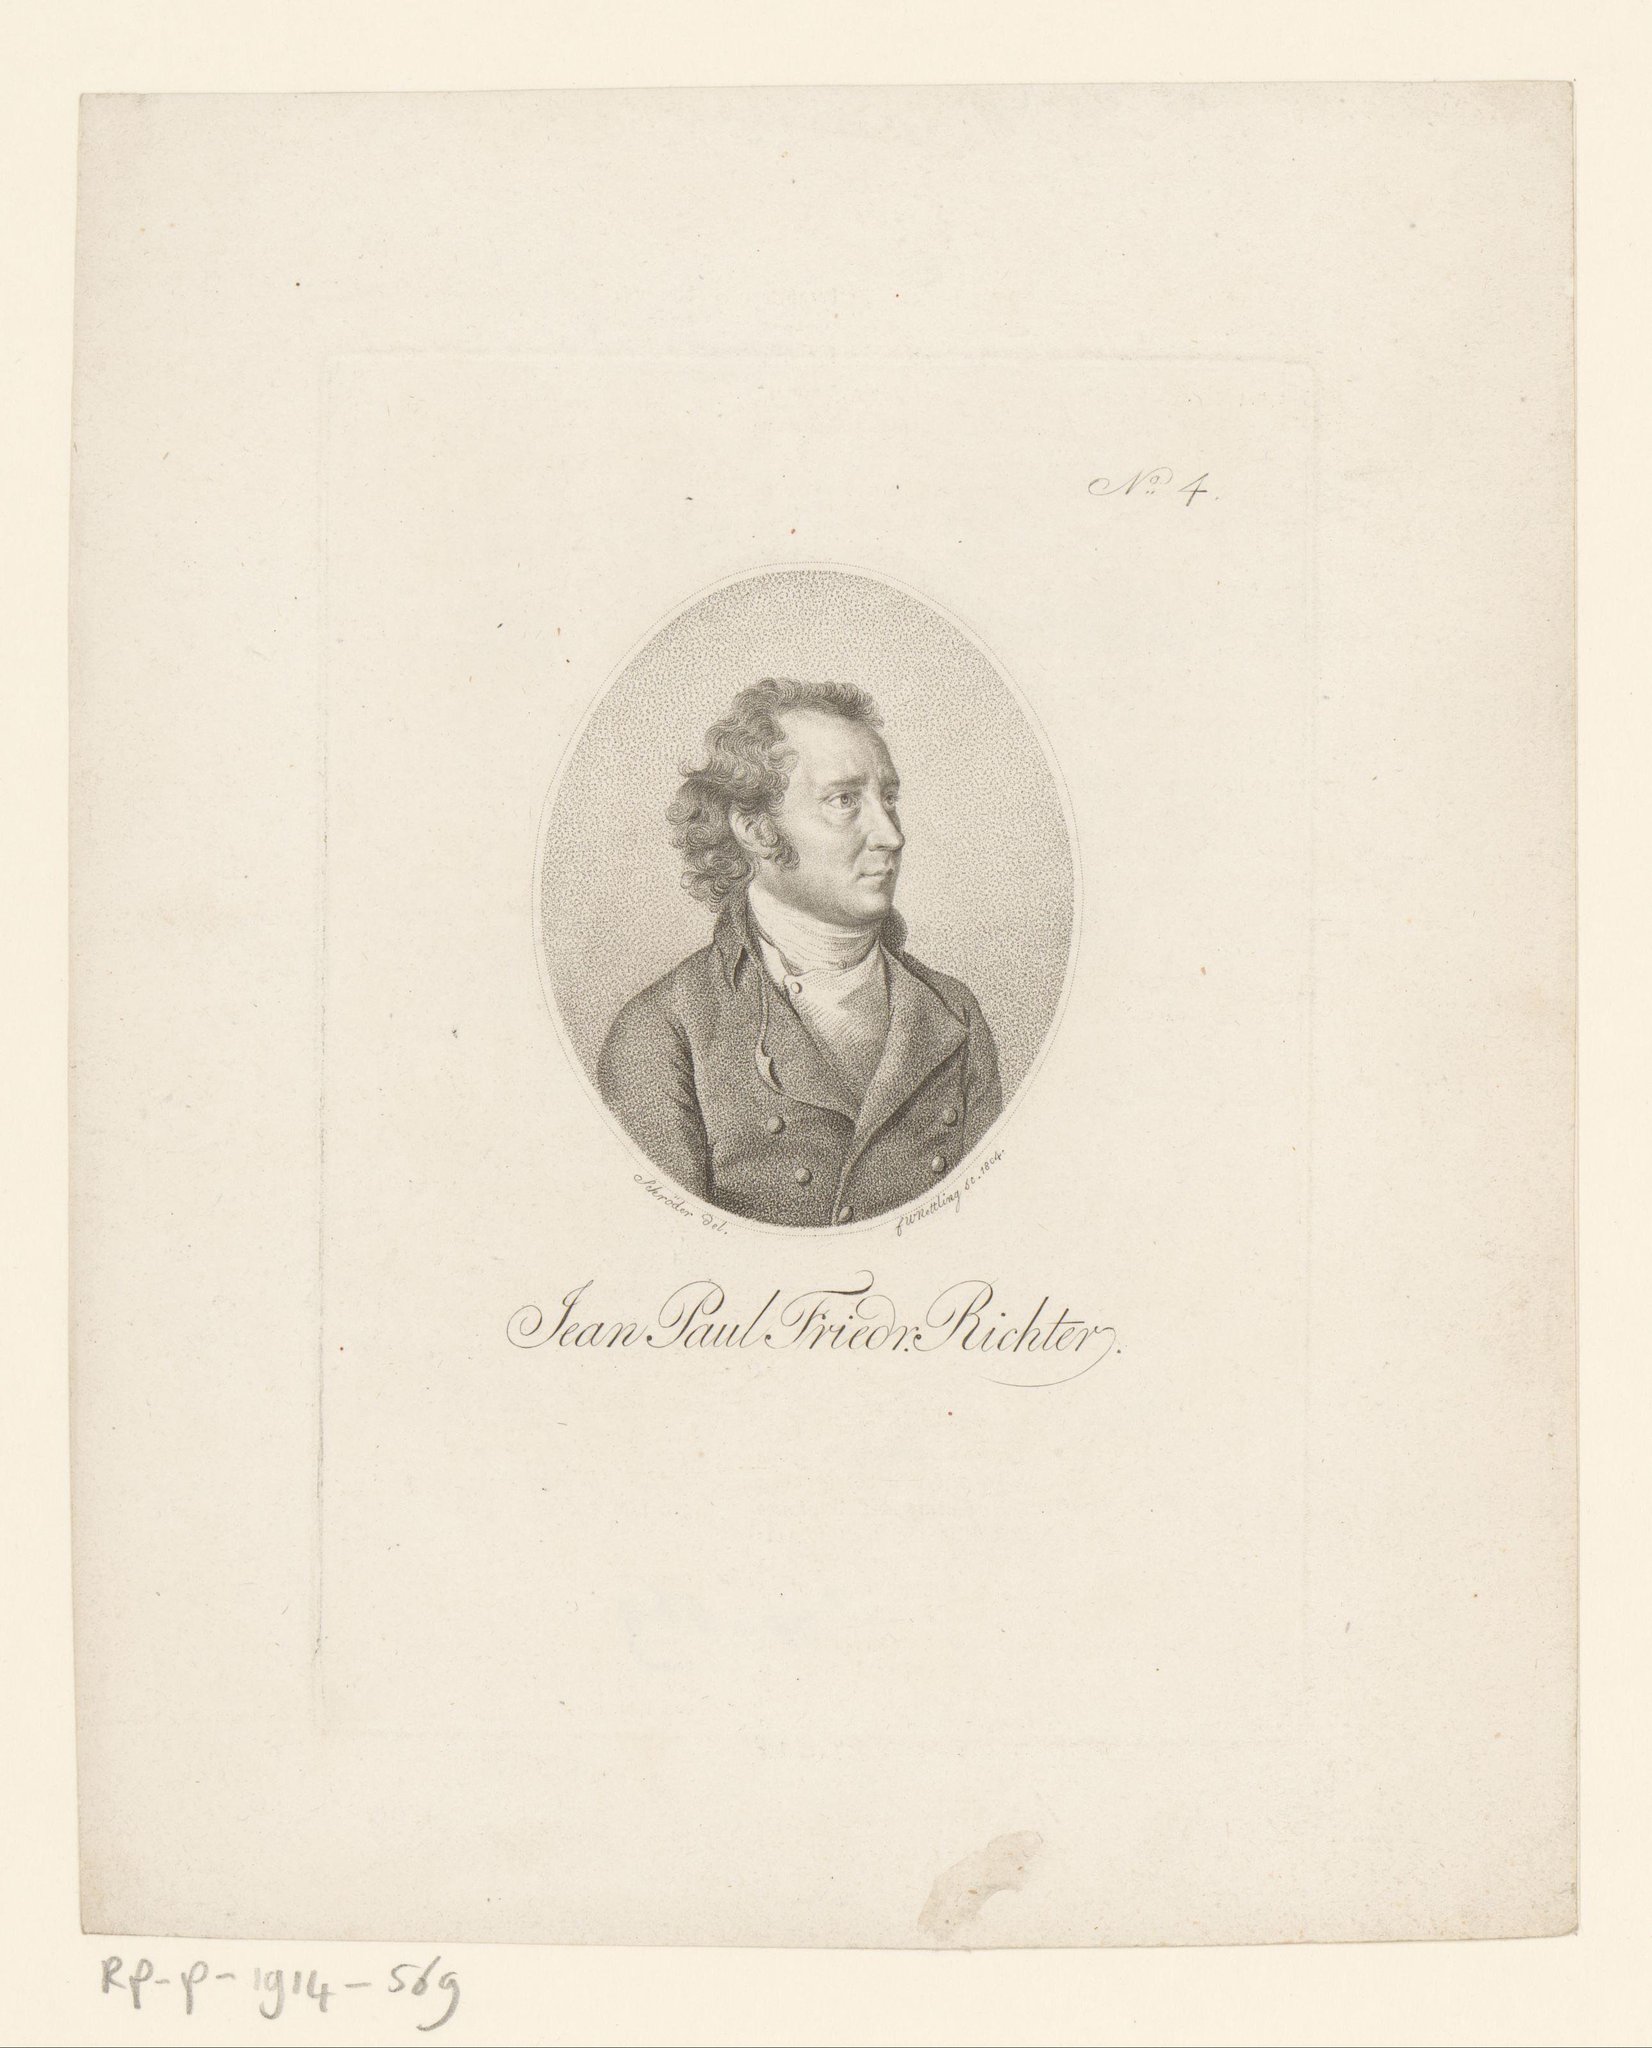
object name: print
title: Portret Jean Paul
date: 1804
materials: paper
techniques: engraving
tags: jean paul, historical persons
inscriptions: collector's mark: Lugt 2228